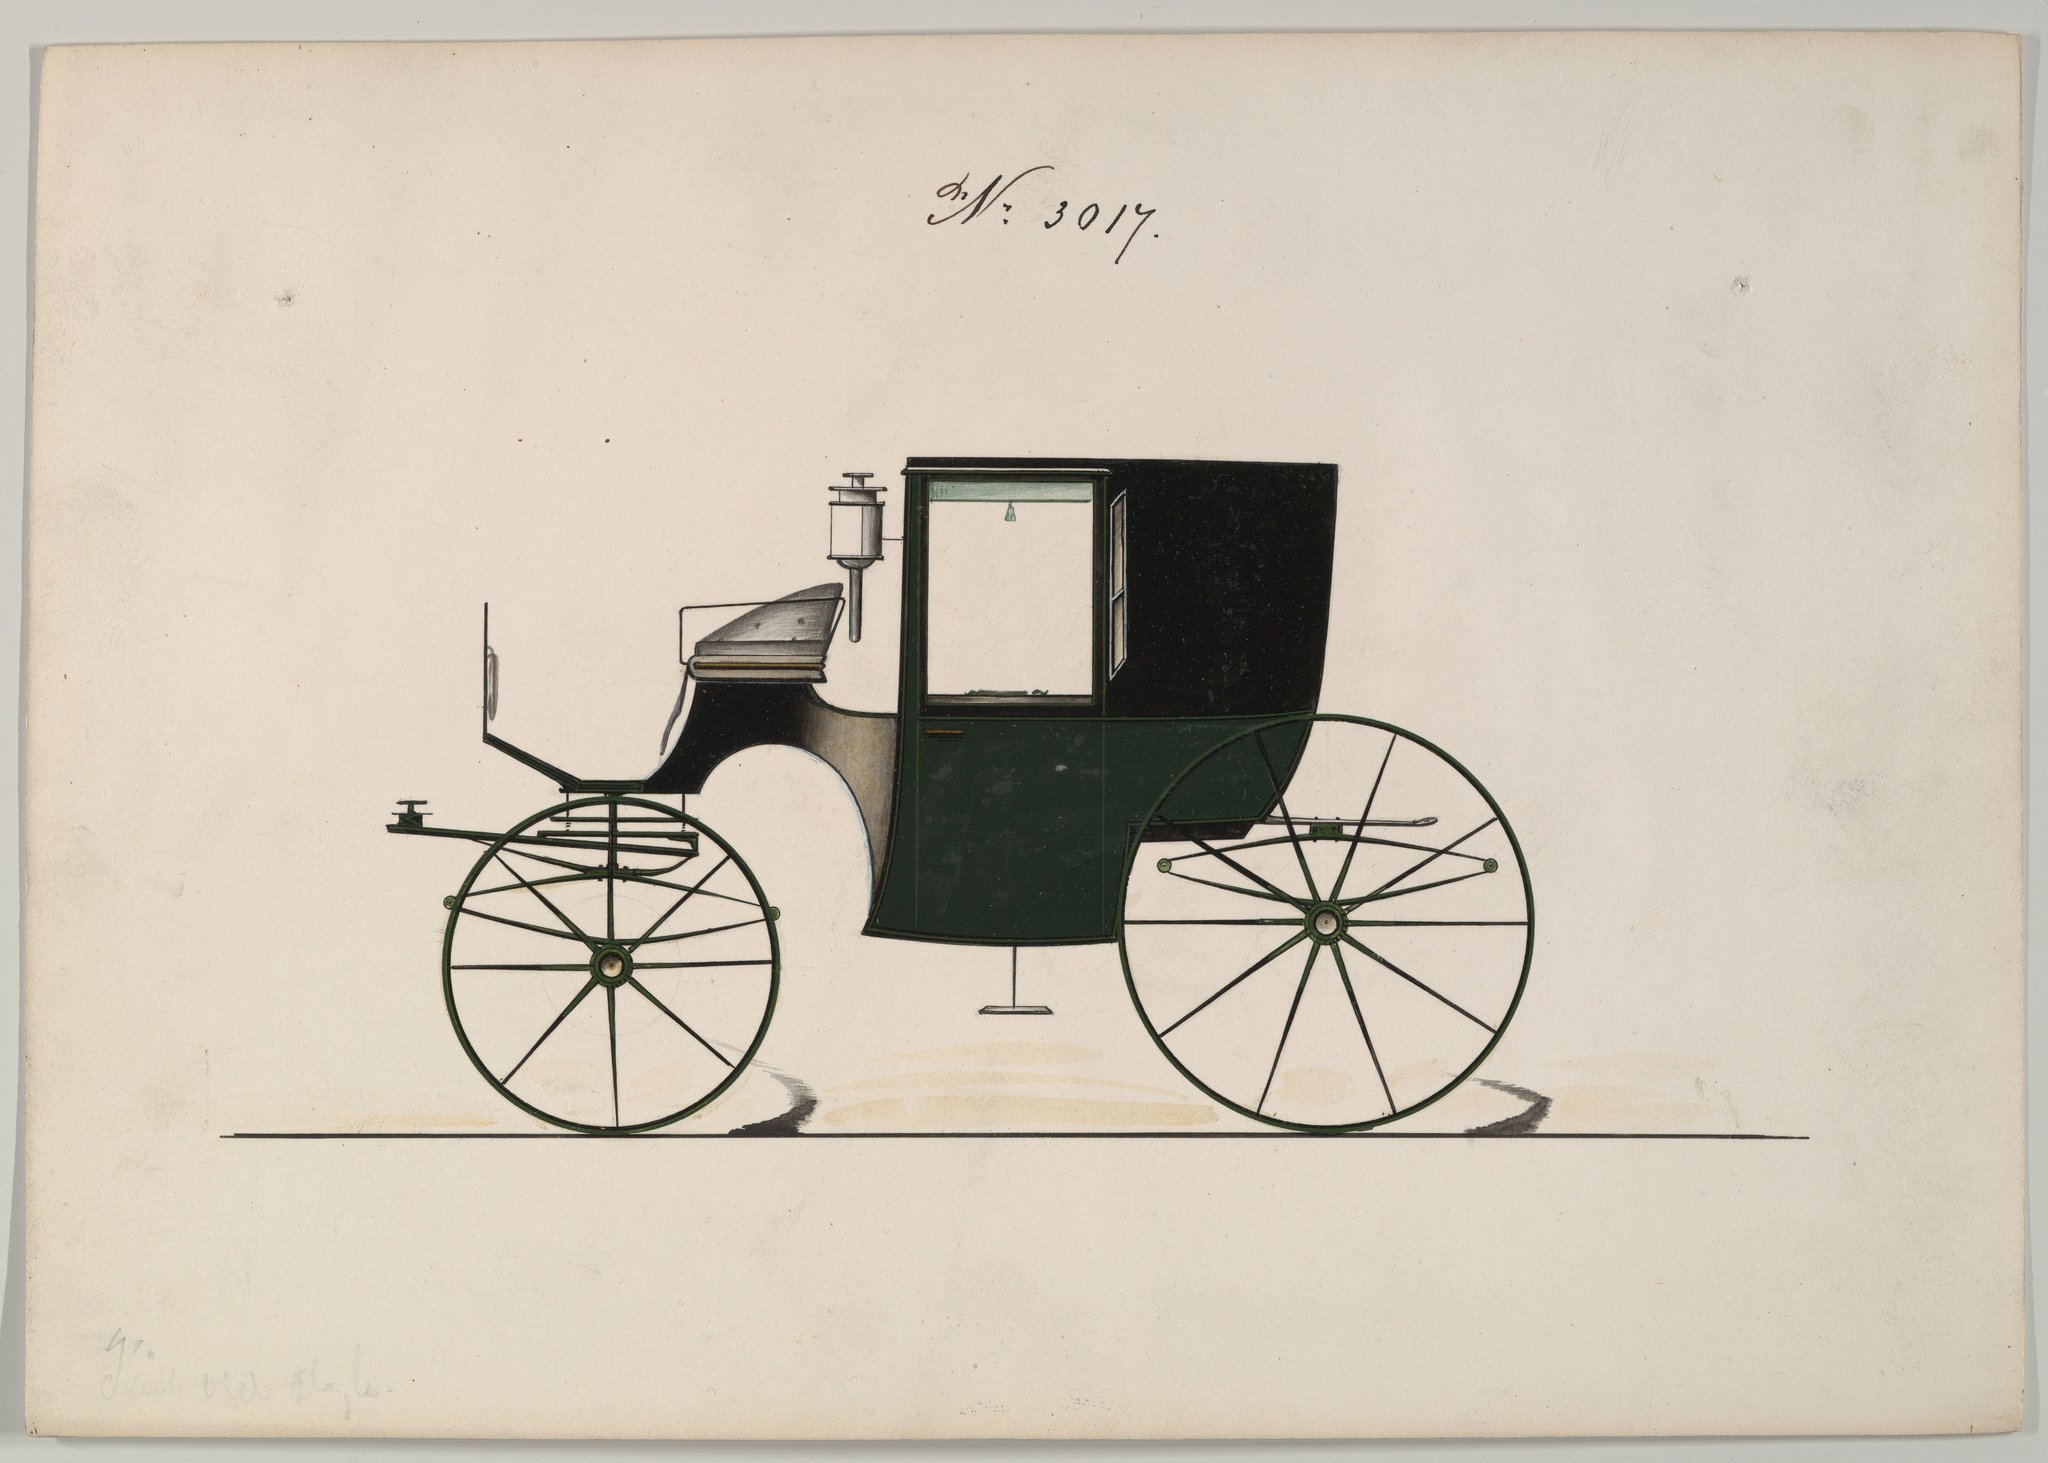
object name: drawing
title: Brougham #3017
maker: brewster & co.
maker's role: manufacturer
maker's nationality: american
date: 1874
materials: gouache, gum arabic, ink, watercolor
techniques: pen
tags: carriages